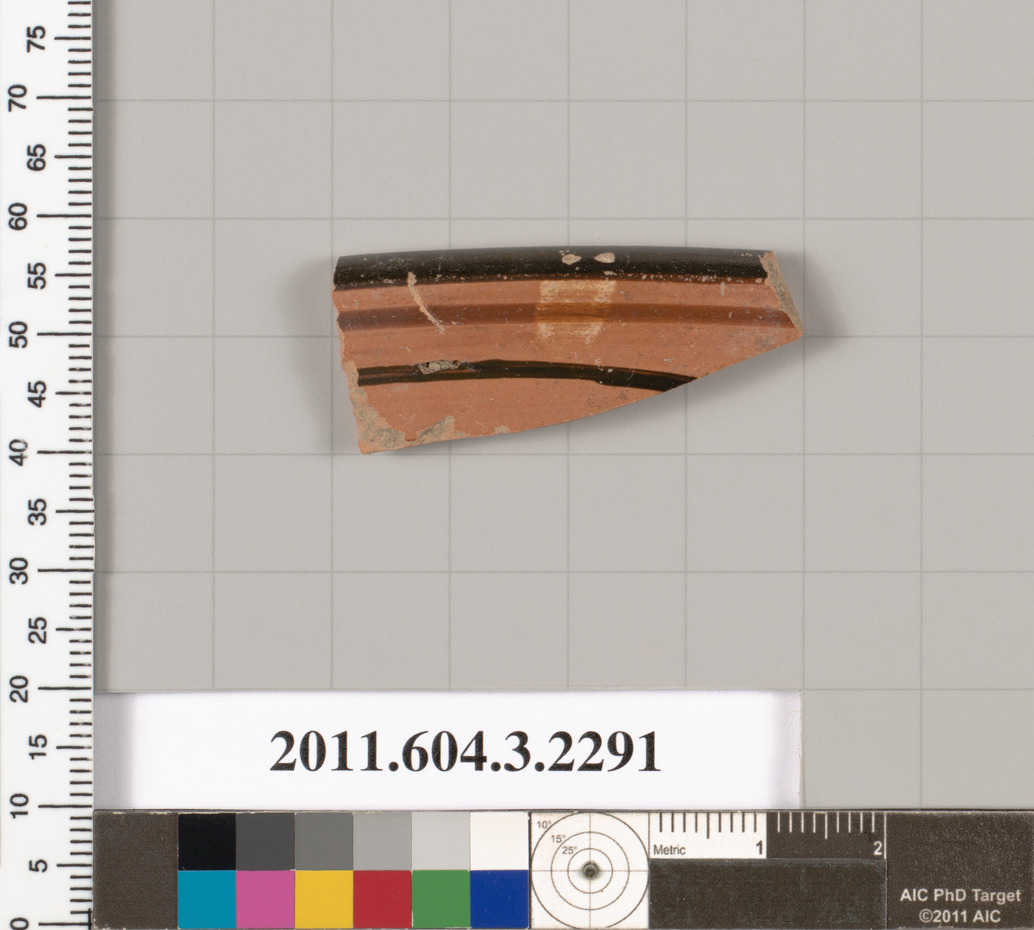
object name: kylix fragment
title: Terracotta rim fragment of a kylix: eye-cup (drinking cup)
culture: greek, attic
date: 540-500 BCE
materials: terracotta